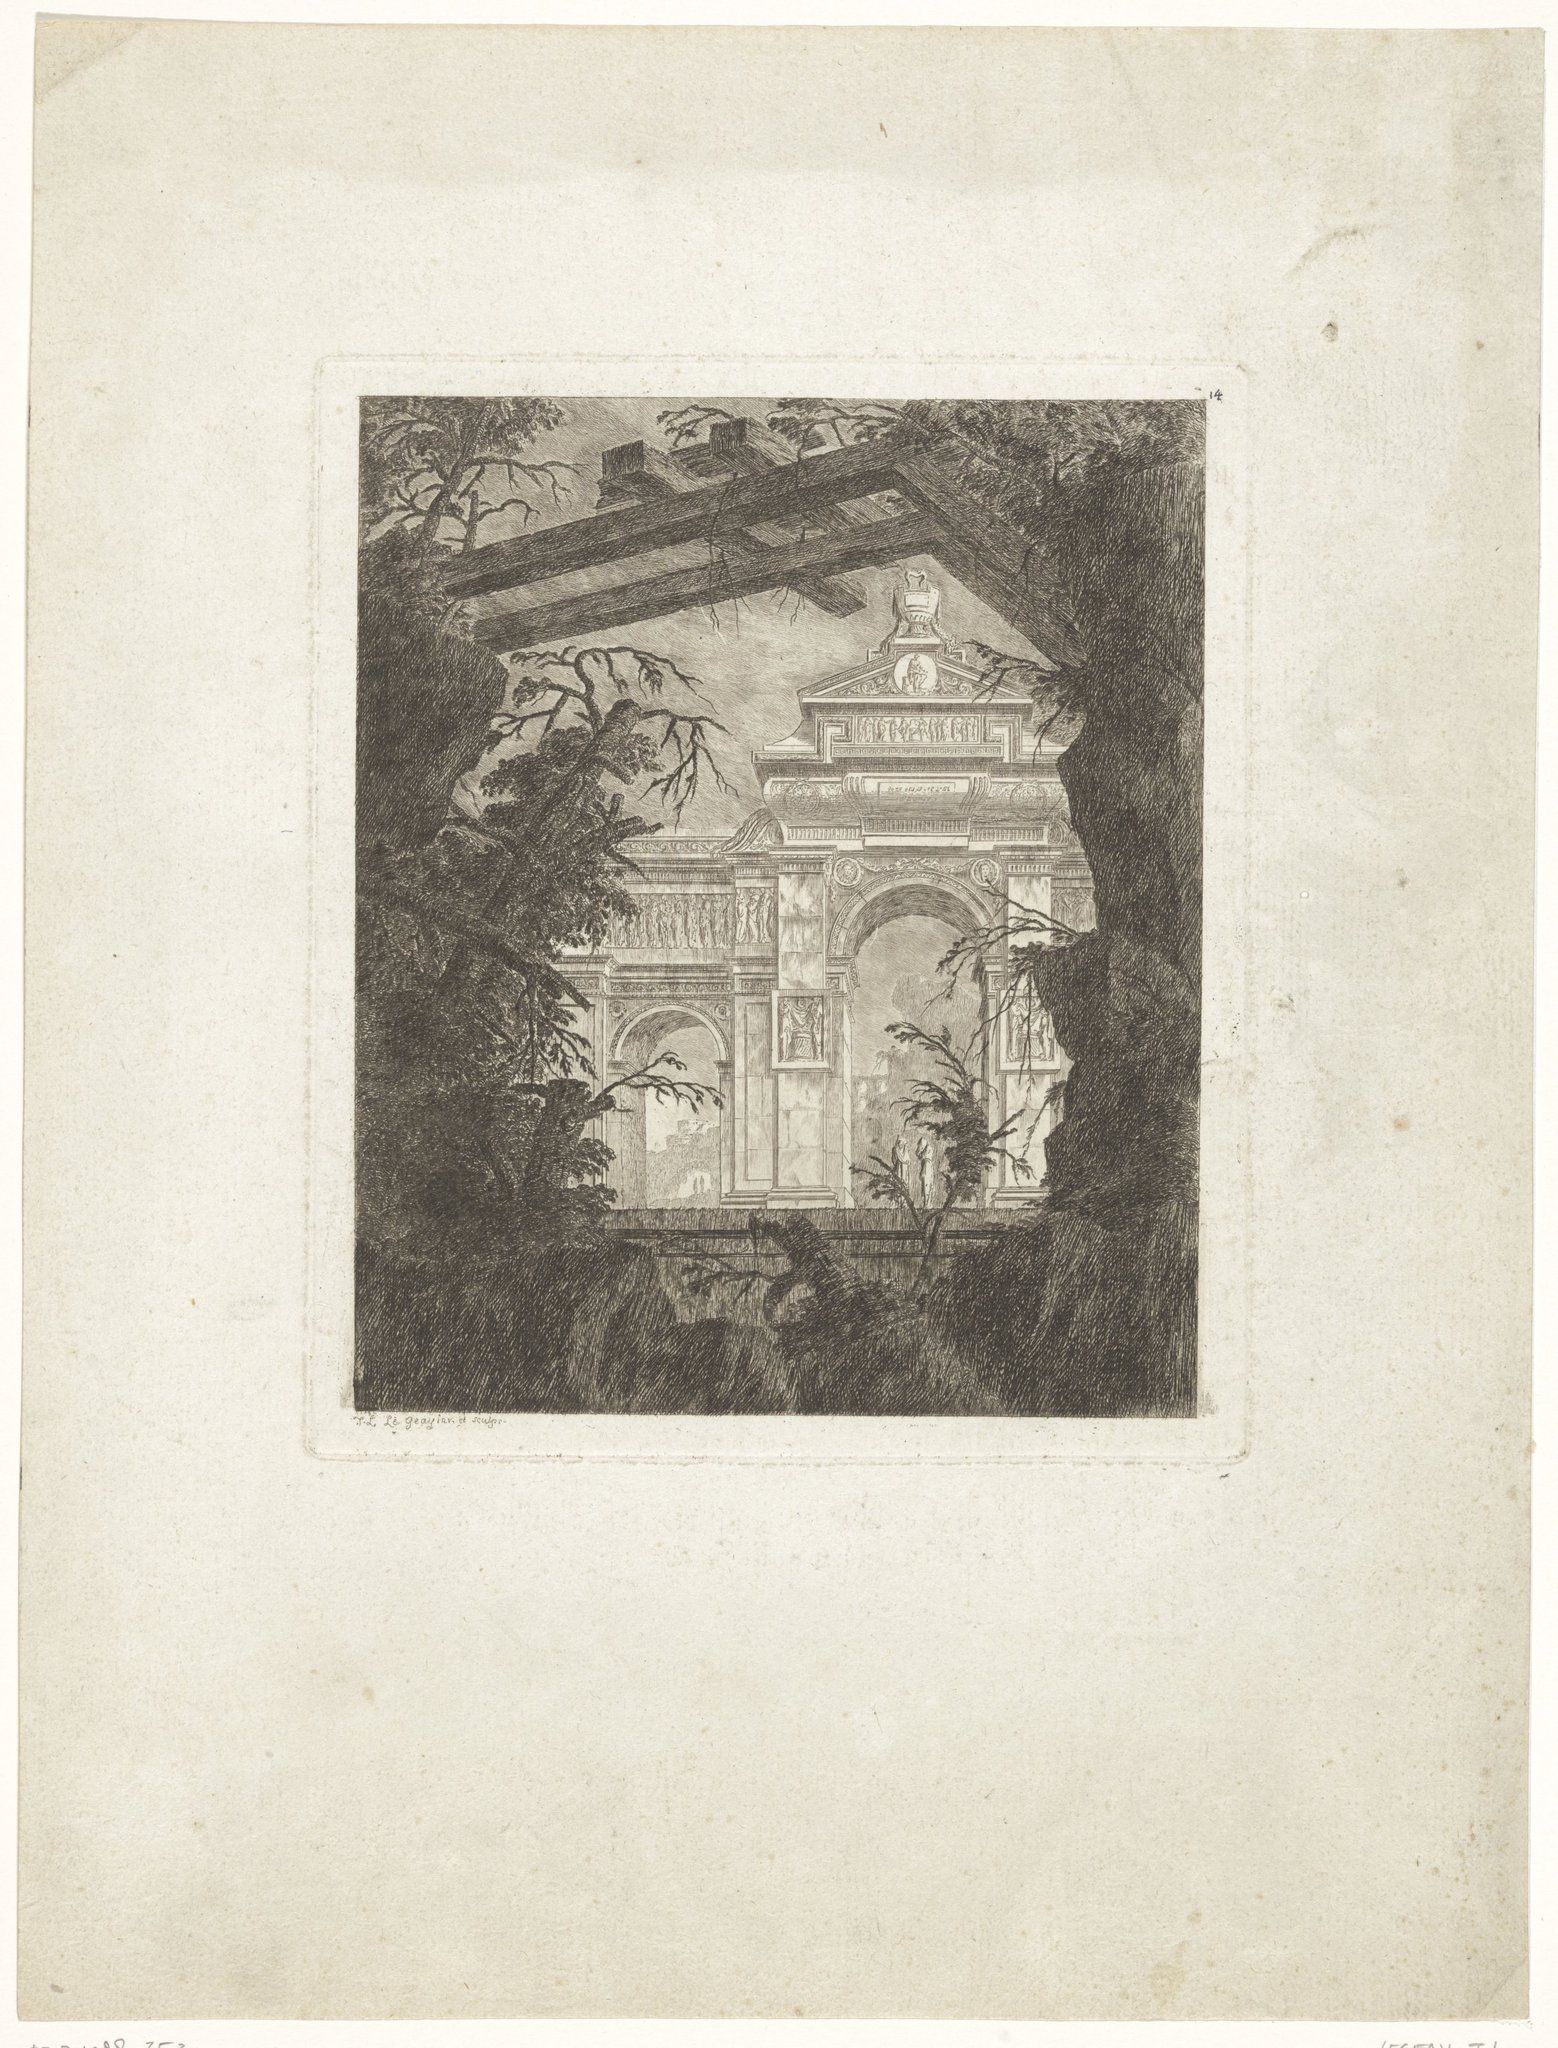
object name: print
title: Architectuurfantasie, blad 14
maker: jean laurent legeay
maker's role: print maker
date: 1767-1768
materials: paper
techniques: etching